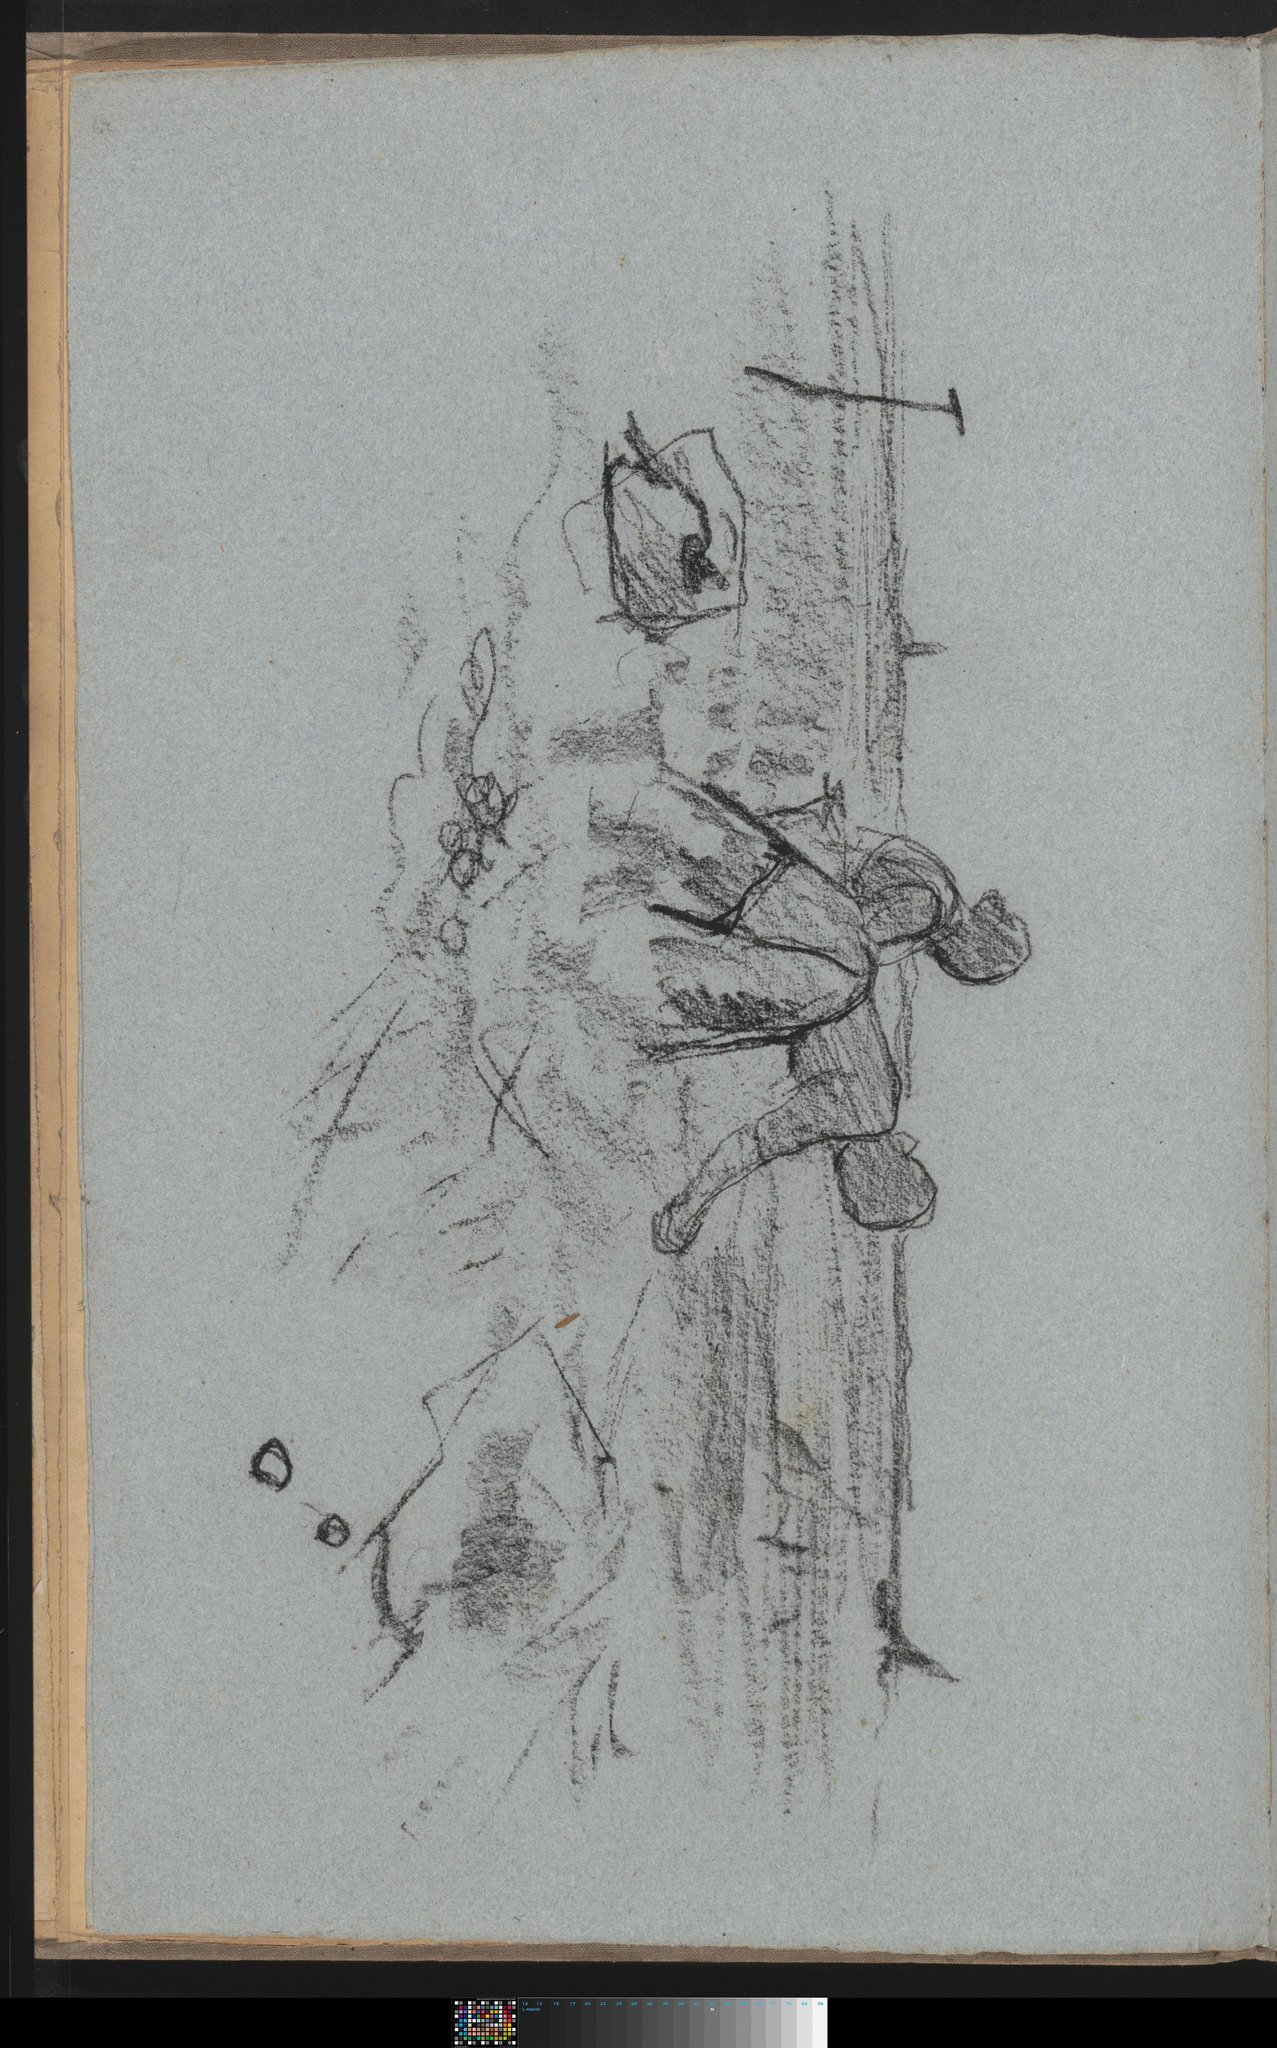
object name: sketchbook leaf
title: Twee aardappelrooisters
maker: willem witsen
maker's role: draughtsman, painter, print maker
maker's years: 1860-1923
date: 1886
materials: chalk, paper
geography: ewijkshoeve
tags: adolescent, young woman, maiden (+ kneeling), potatoes, reaping, picking, mowing ~ harvest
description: Achter hen een mand en een spade. In de verte bebouwing. Pagina 62 uit een schetsboek met 38 bladen betekend rond de Ewijkshoeve.